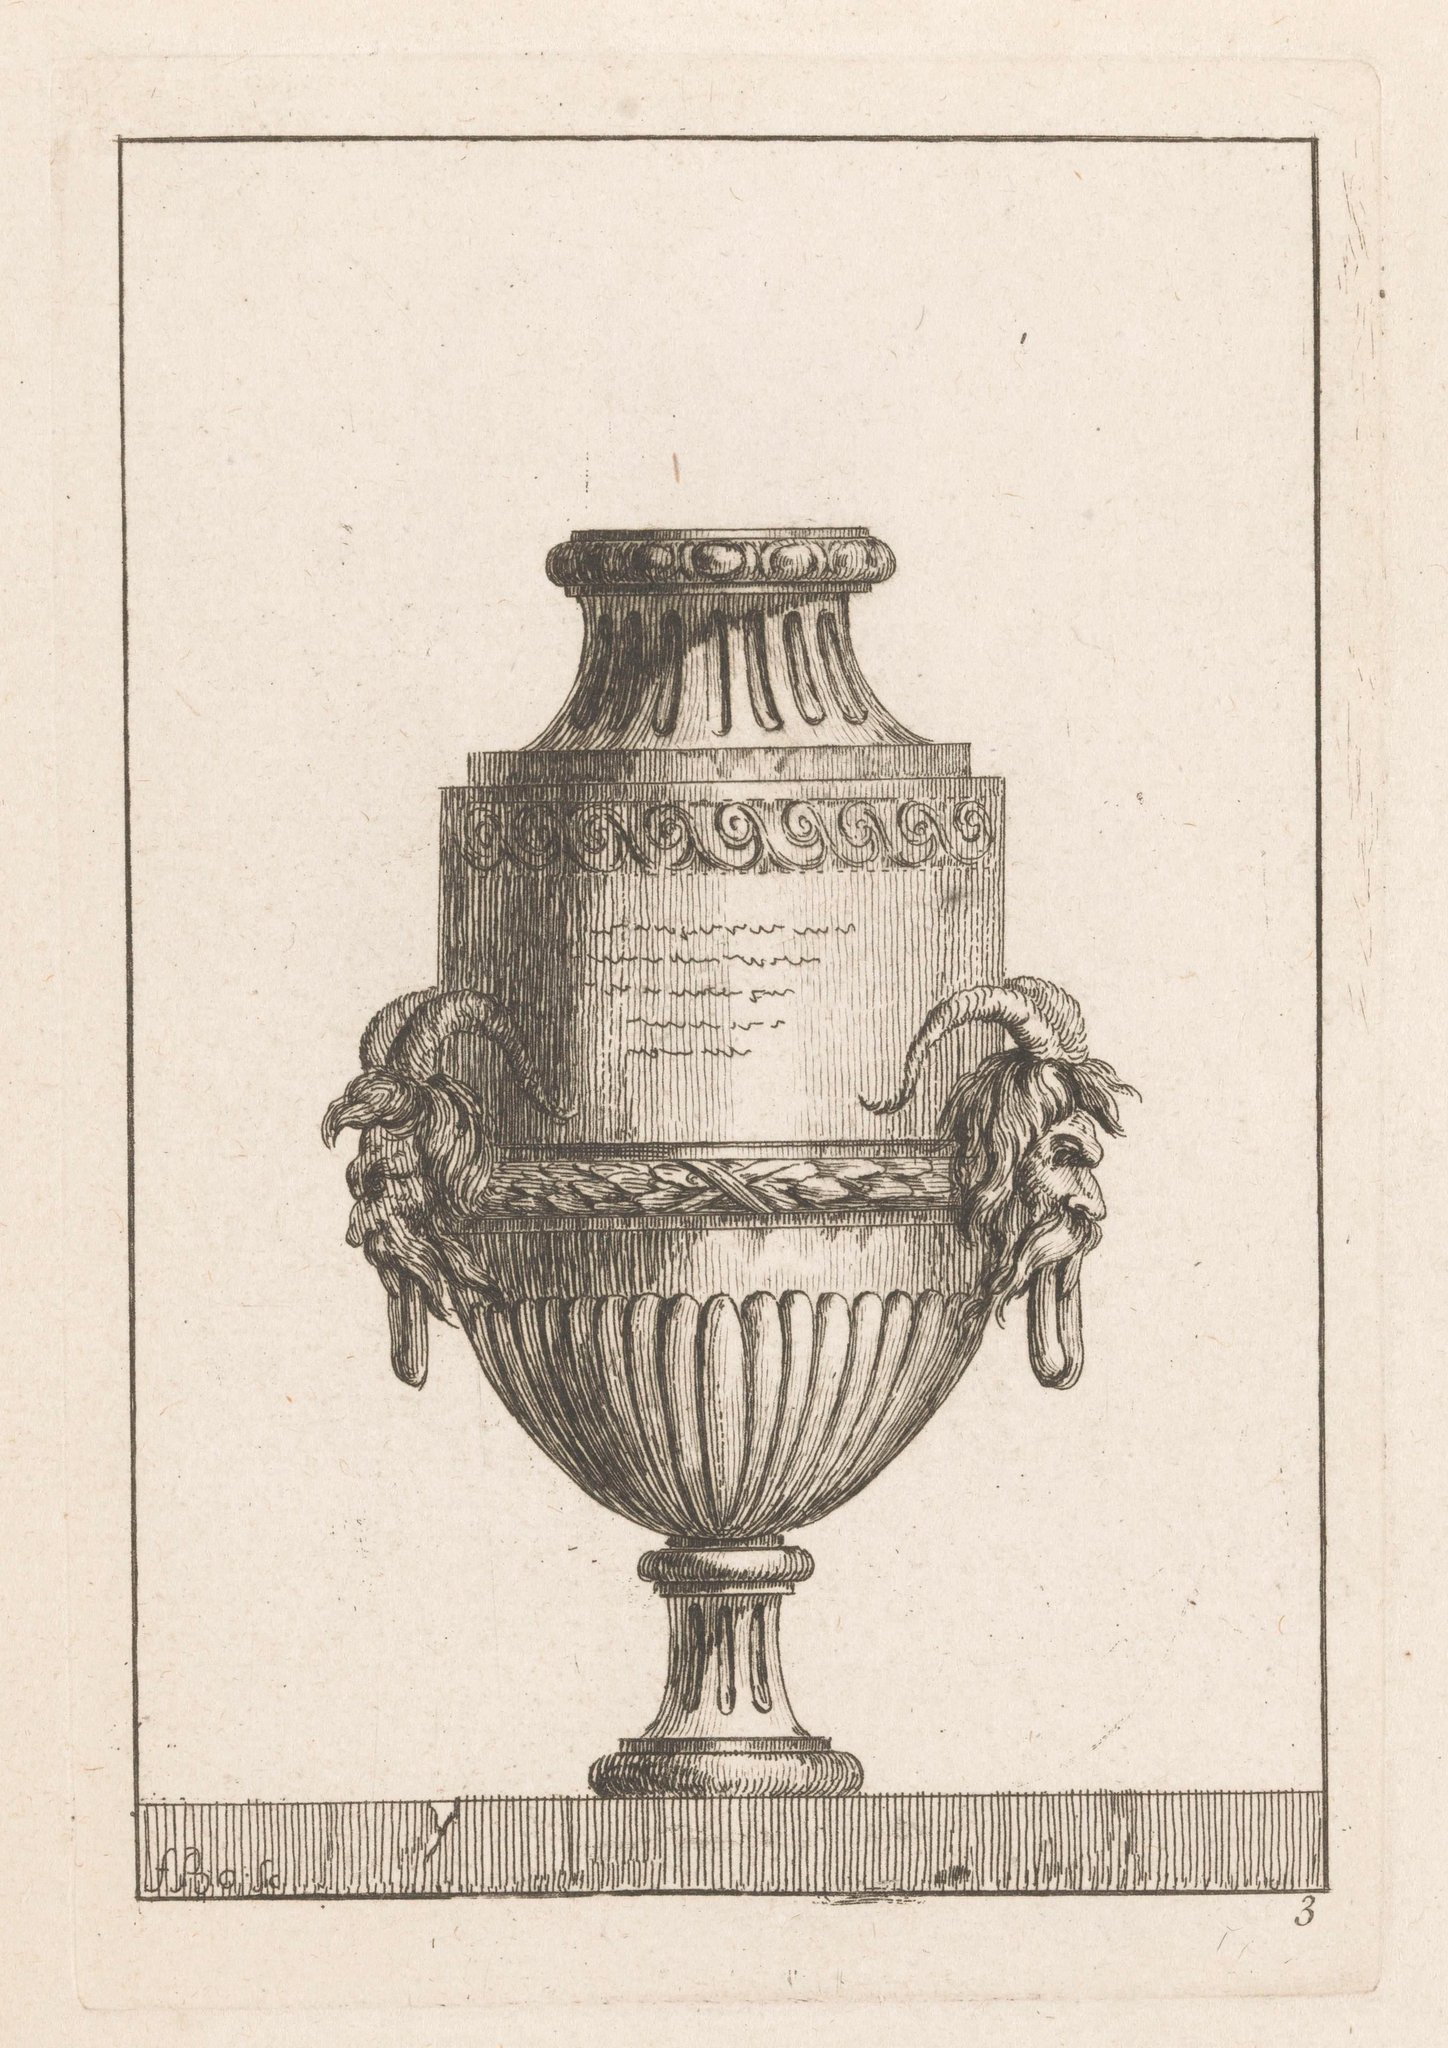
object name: ornament print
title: Vaas met saterkoppen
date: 1755-1782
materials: paper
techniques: etching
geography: paris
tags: vase ~ ornament, satyr(s) (in general)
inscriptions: collector's mark: Lugt 2228, collector's mark: Lugt 2760